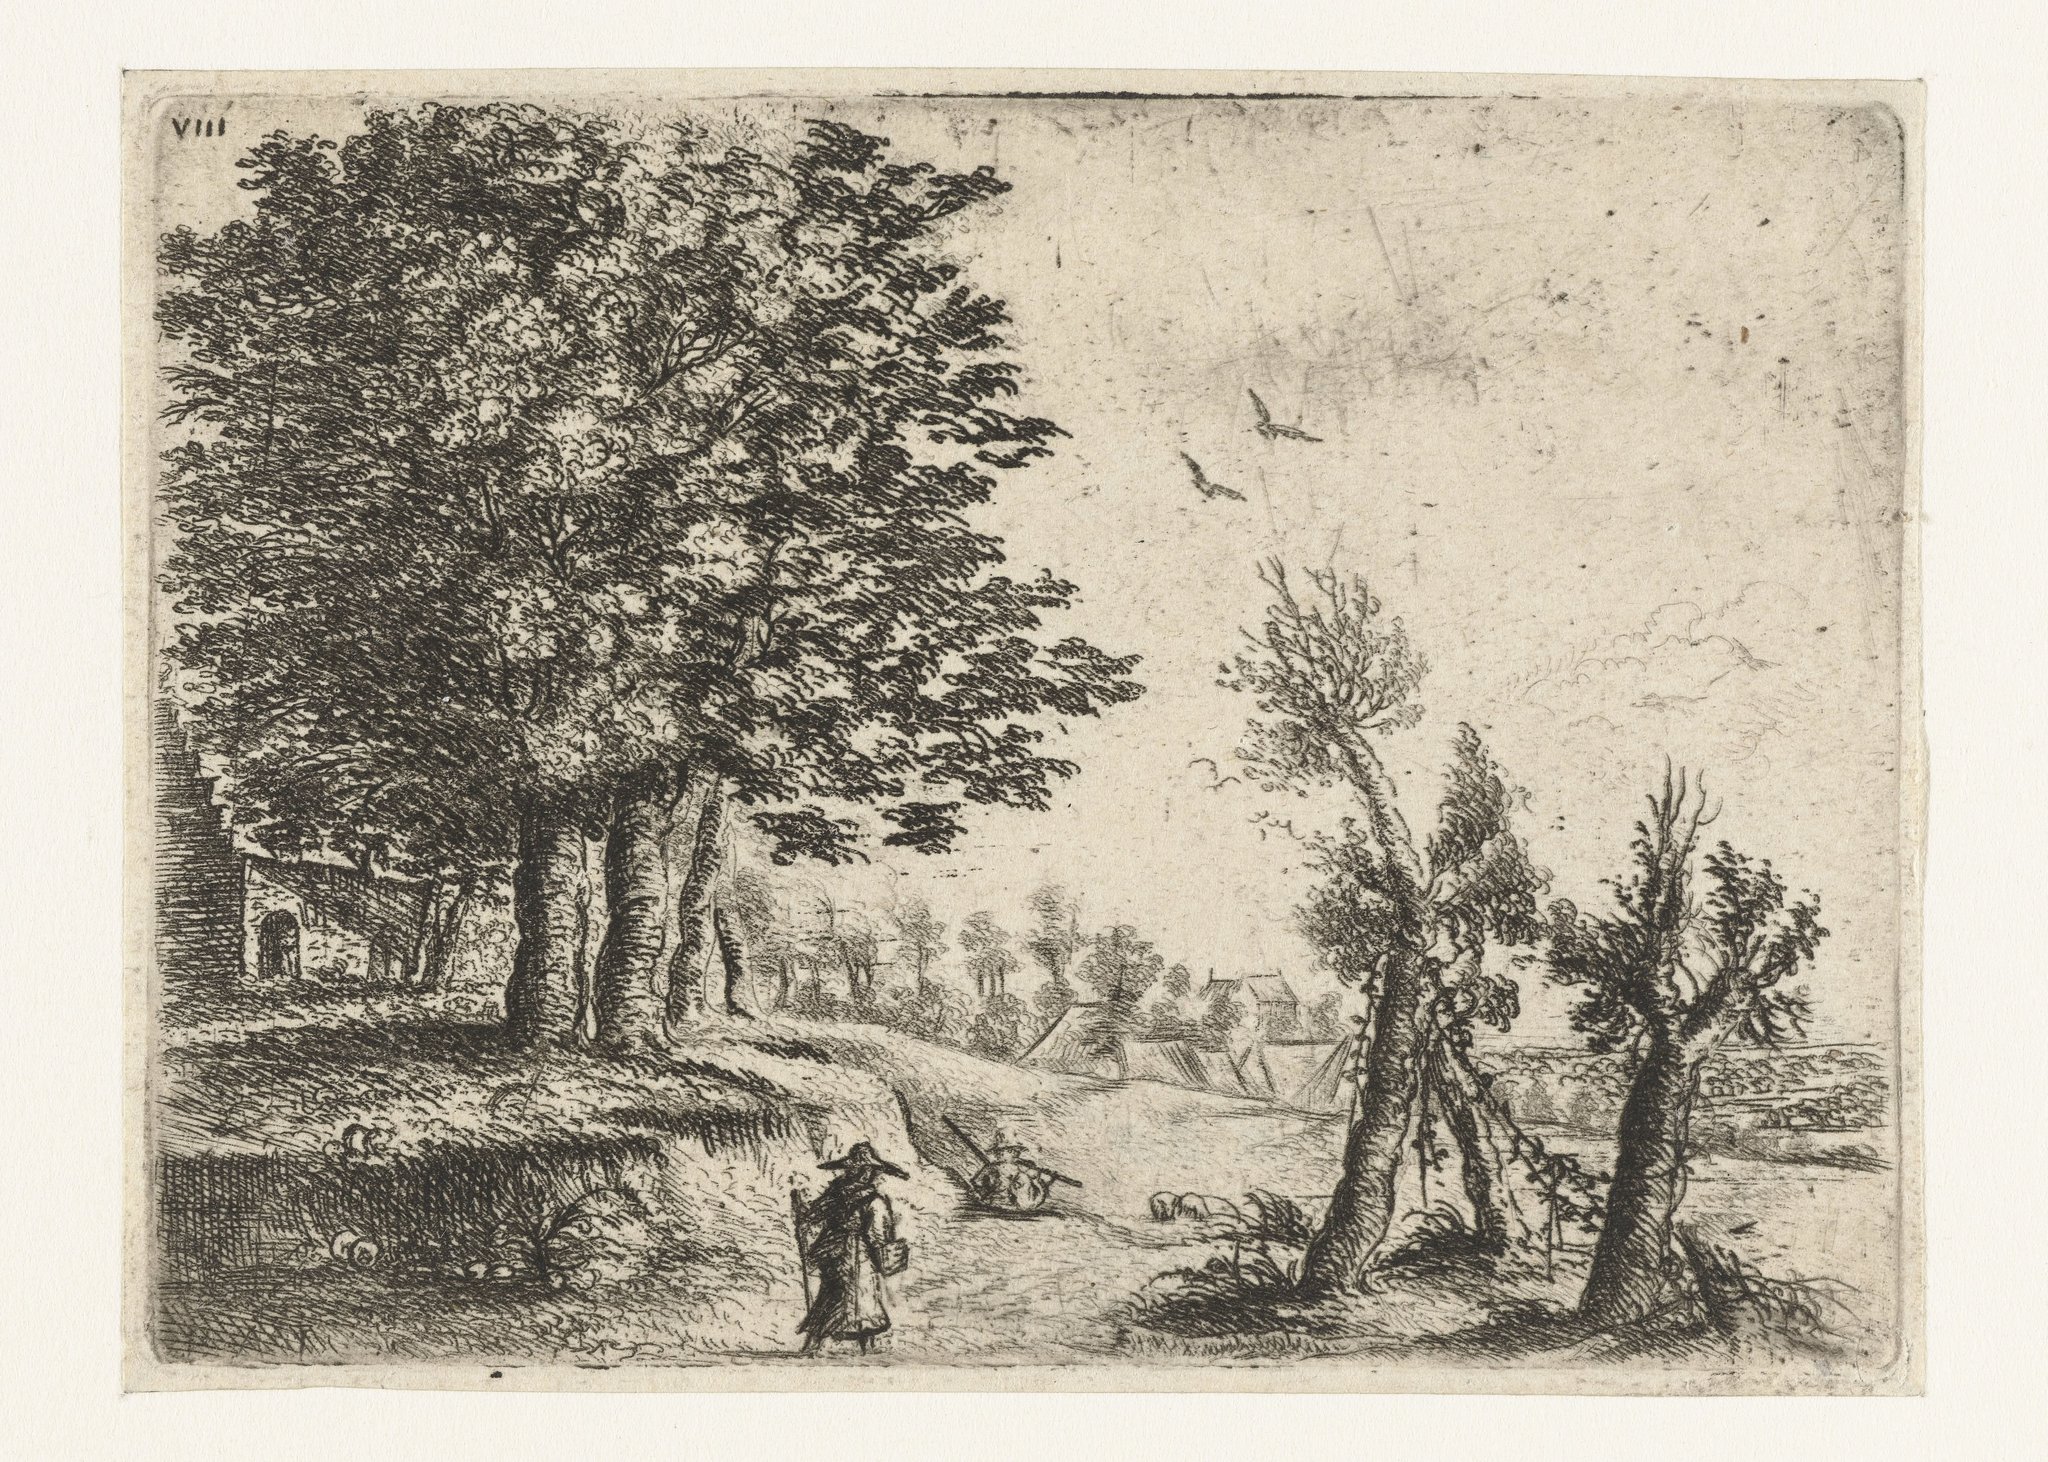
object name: print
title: Acht landschappen naar Lucas van Uden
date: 1637-1679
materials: paper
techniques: engraving, etching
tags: herding, herdsman, herdswoman, shepherd, shepherdess, cowherd, etc., one person playing wind instrument, landscapes in the temperate zone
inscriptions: collector's mark: Lugt 2228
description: Achtste uit serie van acht. Landschap met een wandelende vrouw en een zittende herder spelend op een fluit.